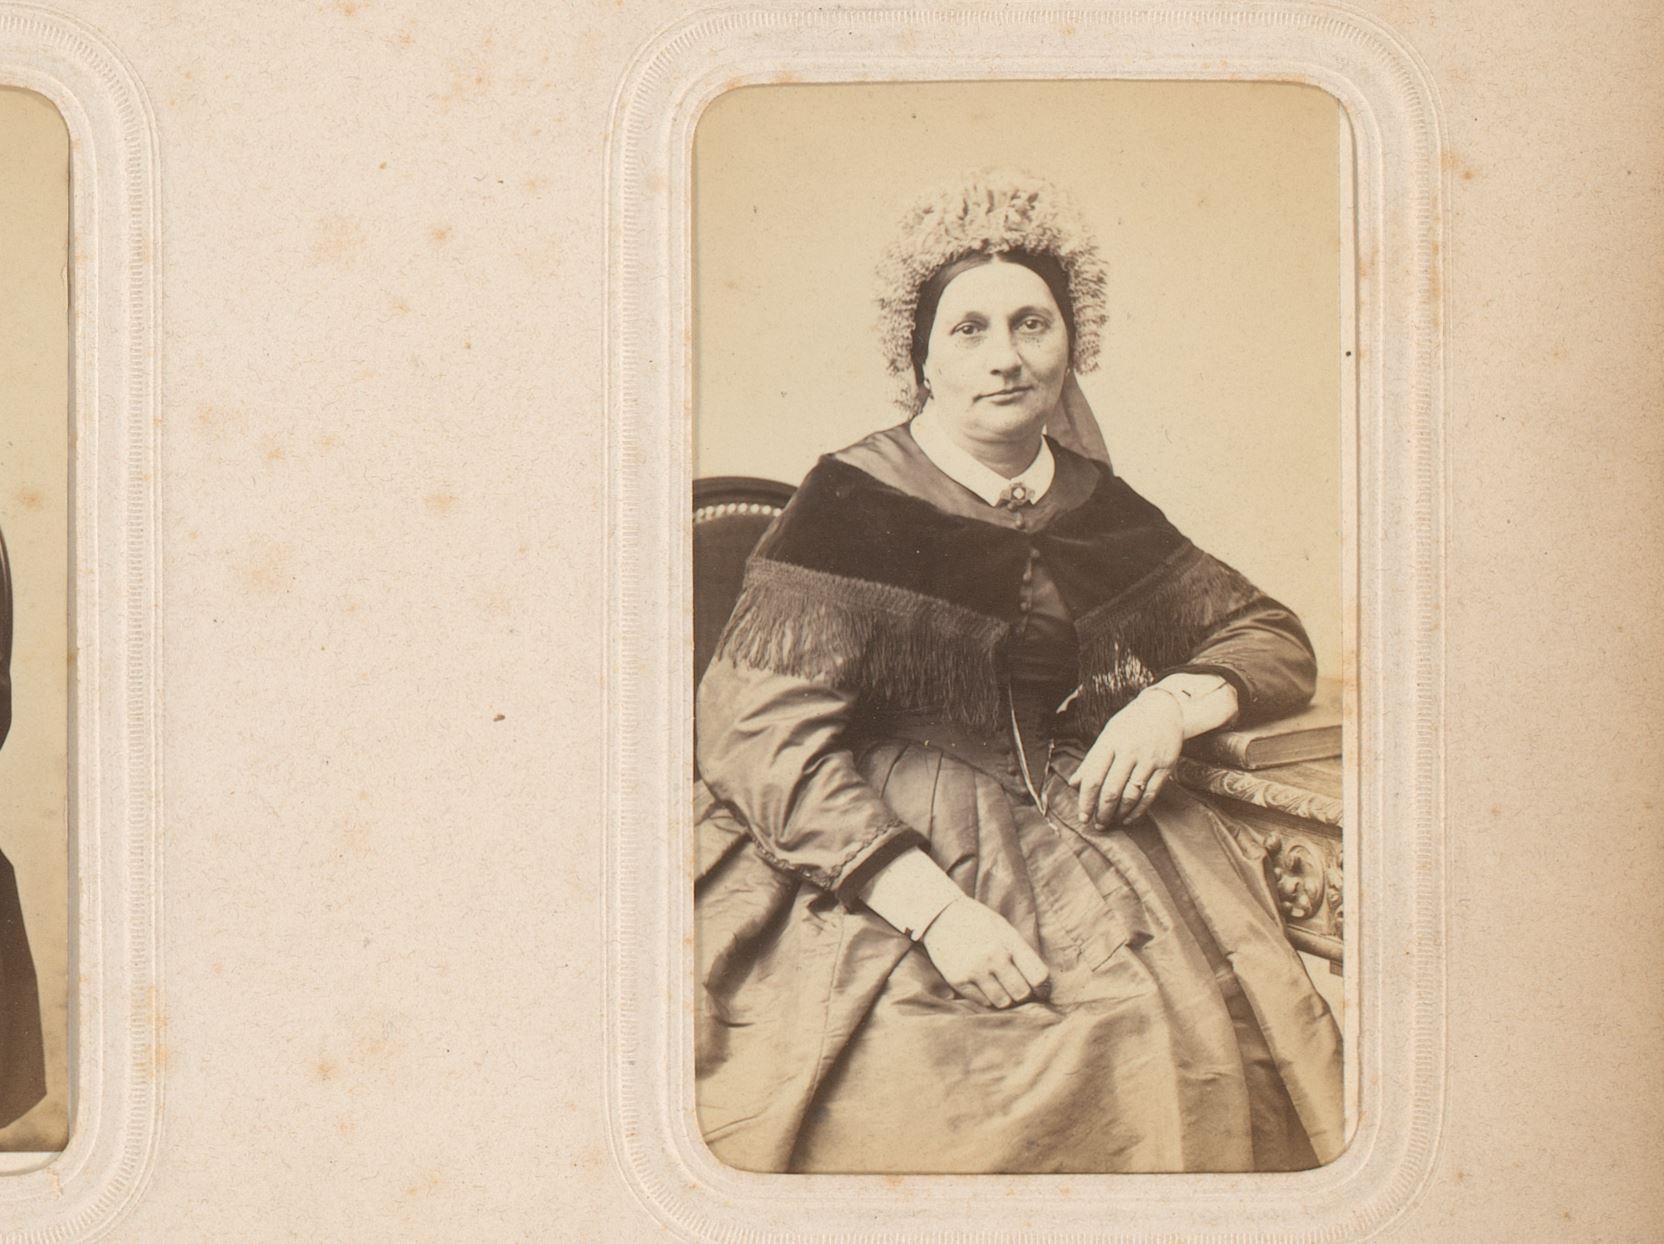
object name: album leaf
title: Portret van een vrouw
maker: jacques-eugène feyen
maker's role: painter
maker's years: 1815-1908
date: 1860-1900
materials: cardboard, photographic support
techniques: albumen print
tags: sitting figure - aa - female human figure, head-gear, historical persons, book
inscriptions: inscription: ‘Photographie/ FeYen/ 17. Rue de la Paix. 17/ Paris’